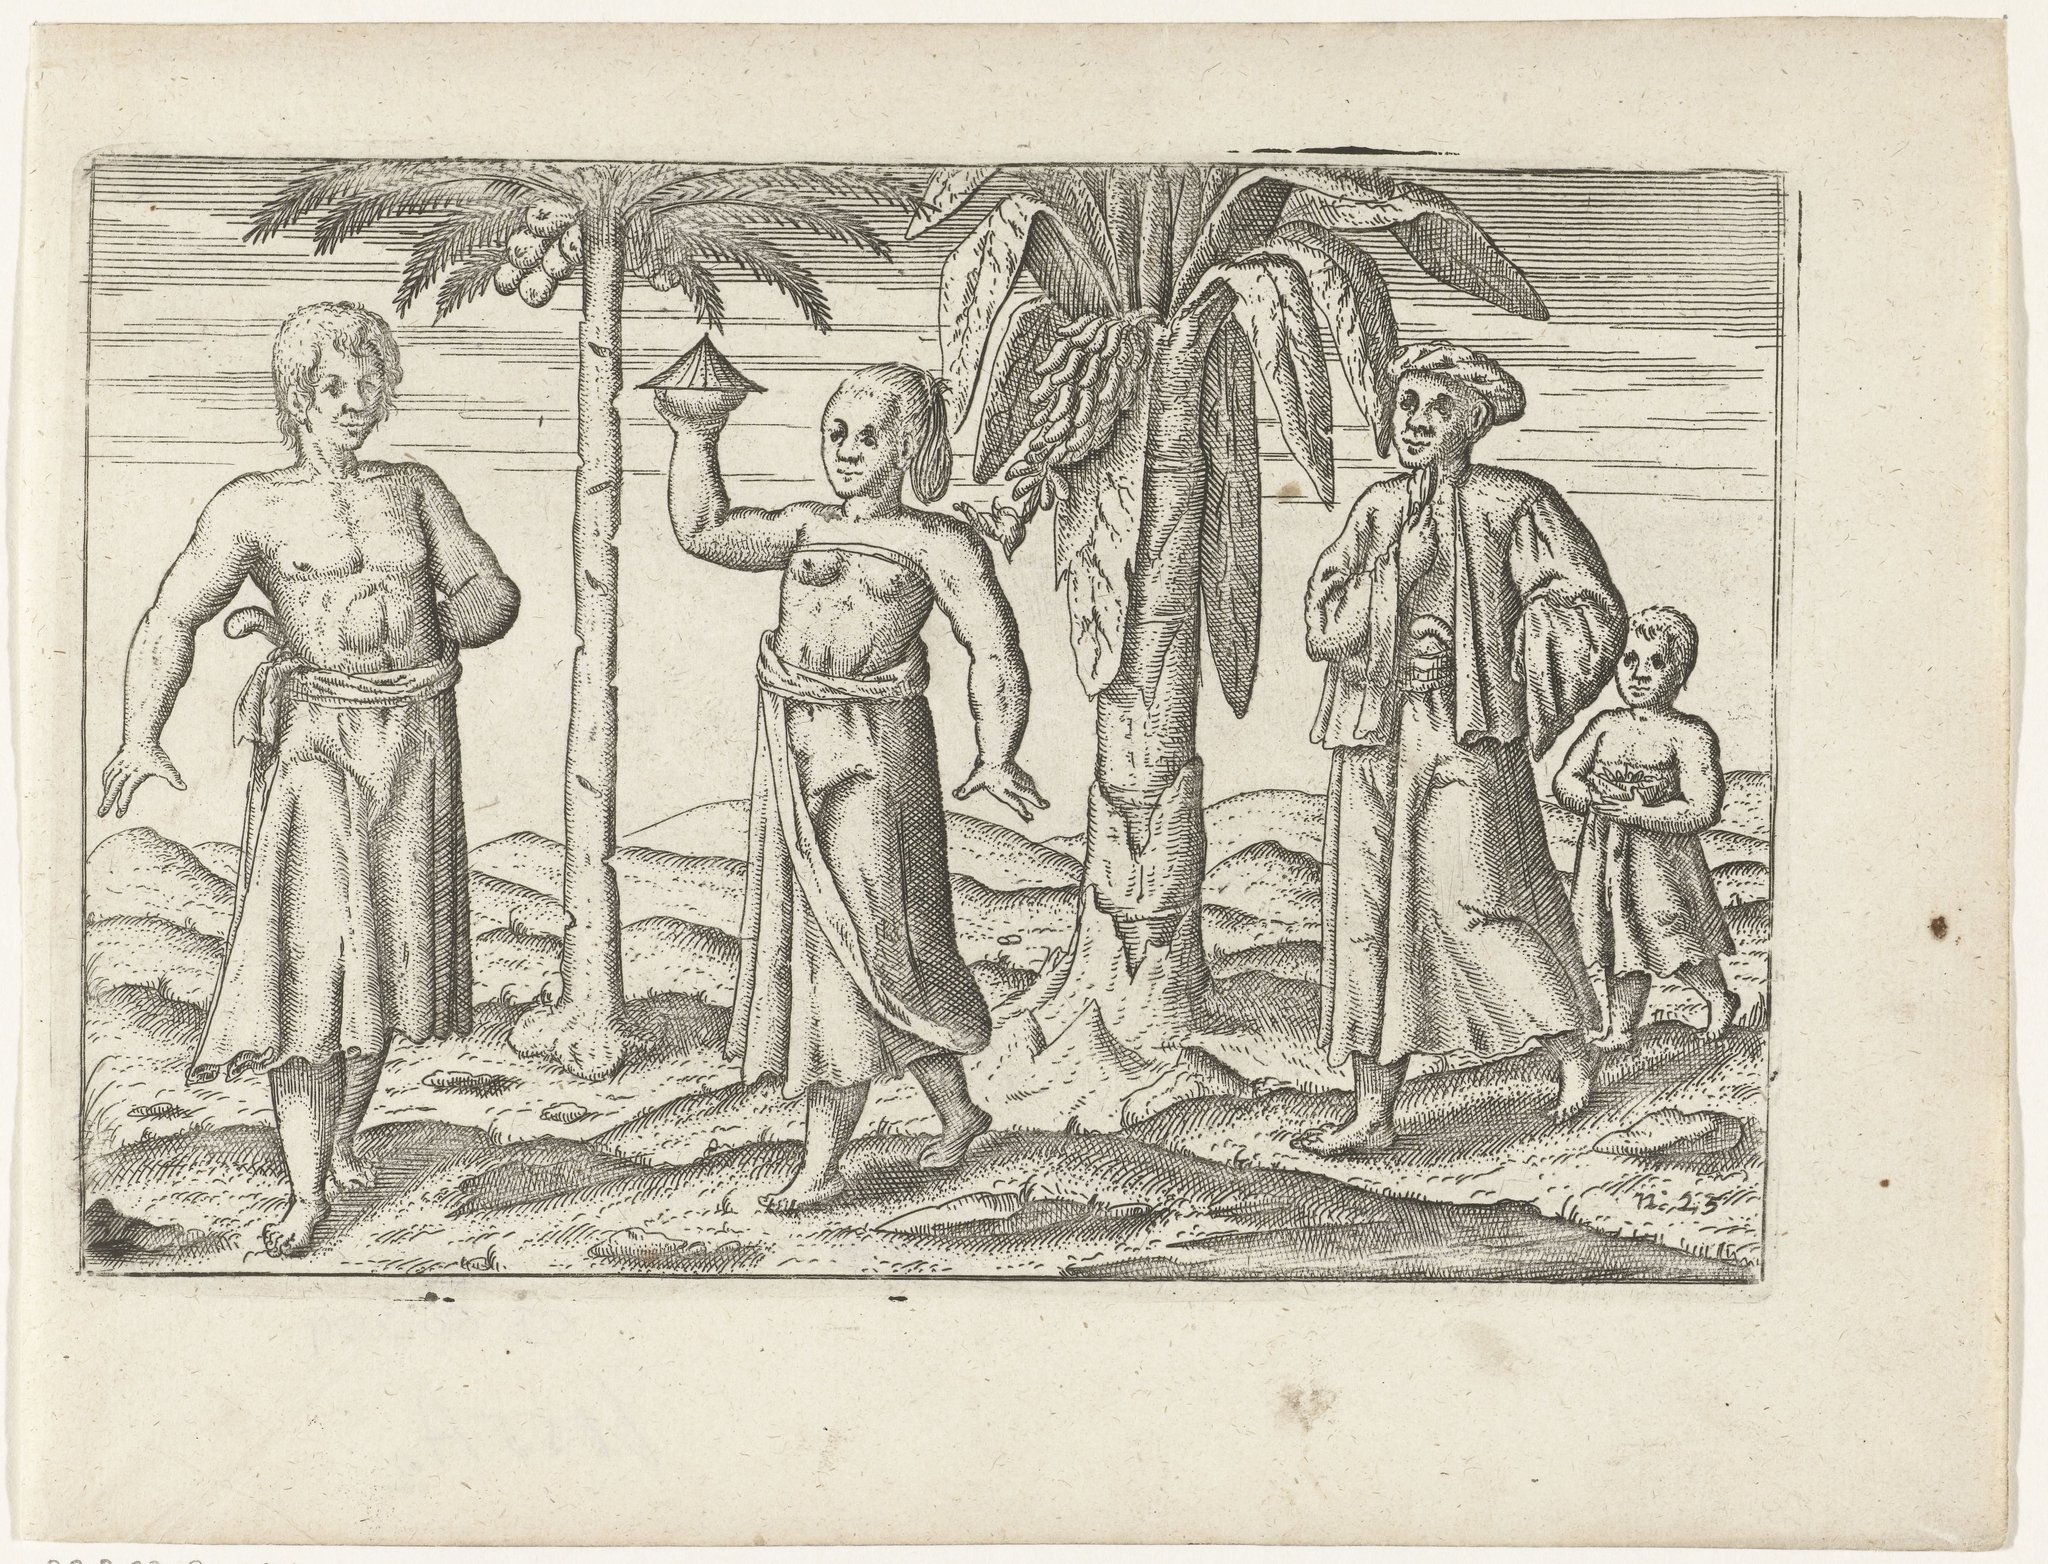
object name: print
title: Javanen en een koopman te Bantam, 1596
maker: Anonymous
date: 1597-1598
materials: paper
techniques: engraving, etching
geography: northern netherlands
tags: landscapes in tropical and sub-tropical regions, exploration, expedition, voyage of discovery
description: Gebruikt als illustratie eerst in: Willem Lodewijcksz, D'eerste boeck. Historie van Indien, waer inne verhaelt is de avontueren die de Hollandtsche schepen bejeghent zijn, Cornelis Claes, Amsterdam 1598. In deze opgewerkte staat gebruikt in: De Eerste Schipvaerd der Hollandsche Natie naer Oost-Indien, waer inne verhaelt wordt al wat haer sonderlings onder wegen bejegent is ... ghetrocken uyt verscheyden Iournalen ofte dagh-registers daer van ghemaeckt, zeer vermaeckelijck ende nut om lesen. Opgenomen in: I. Commelin, Begin ende voortgangh, van de Vereenighde Nederlantsche Geoctroyeerde Oost-Indische Compagnie, J. Janssonius, Amsterdam 1646. Genummerd: 25.